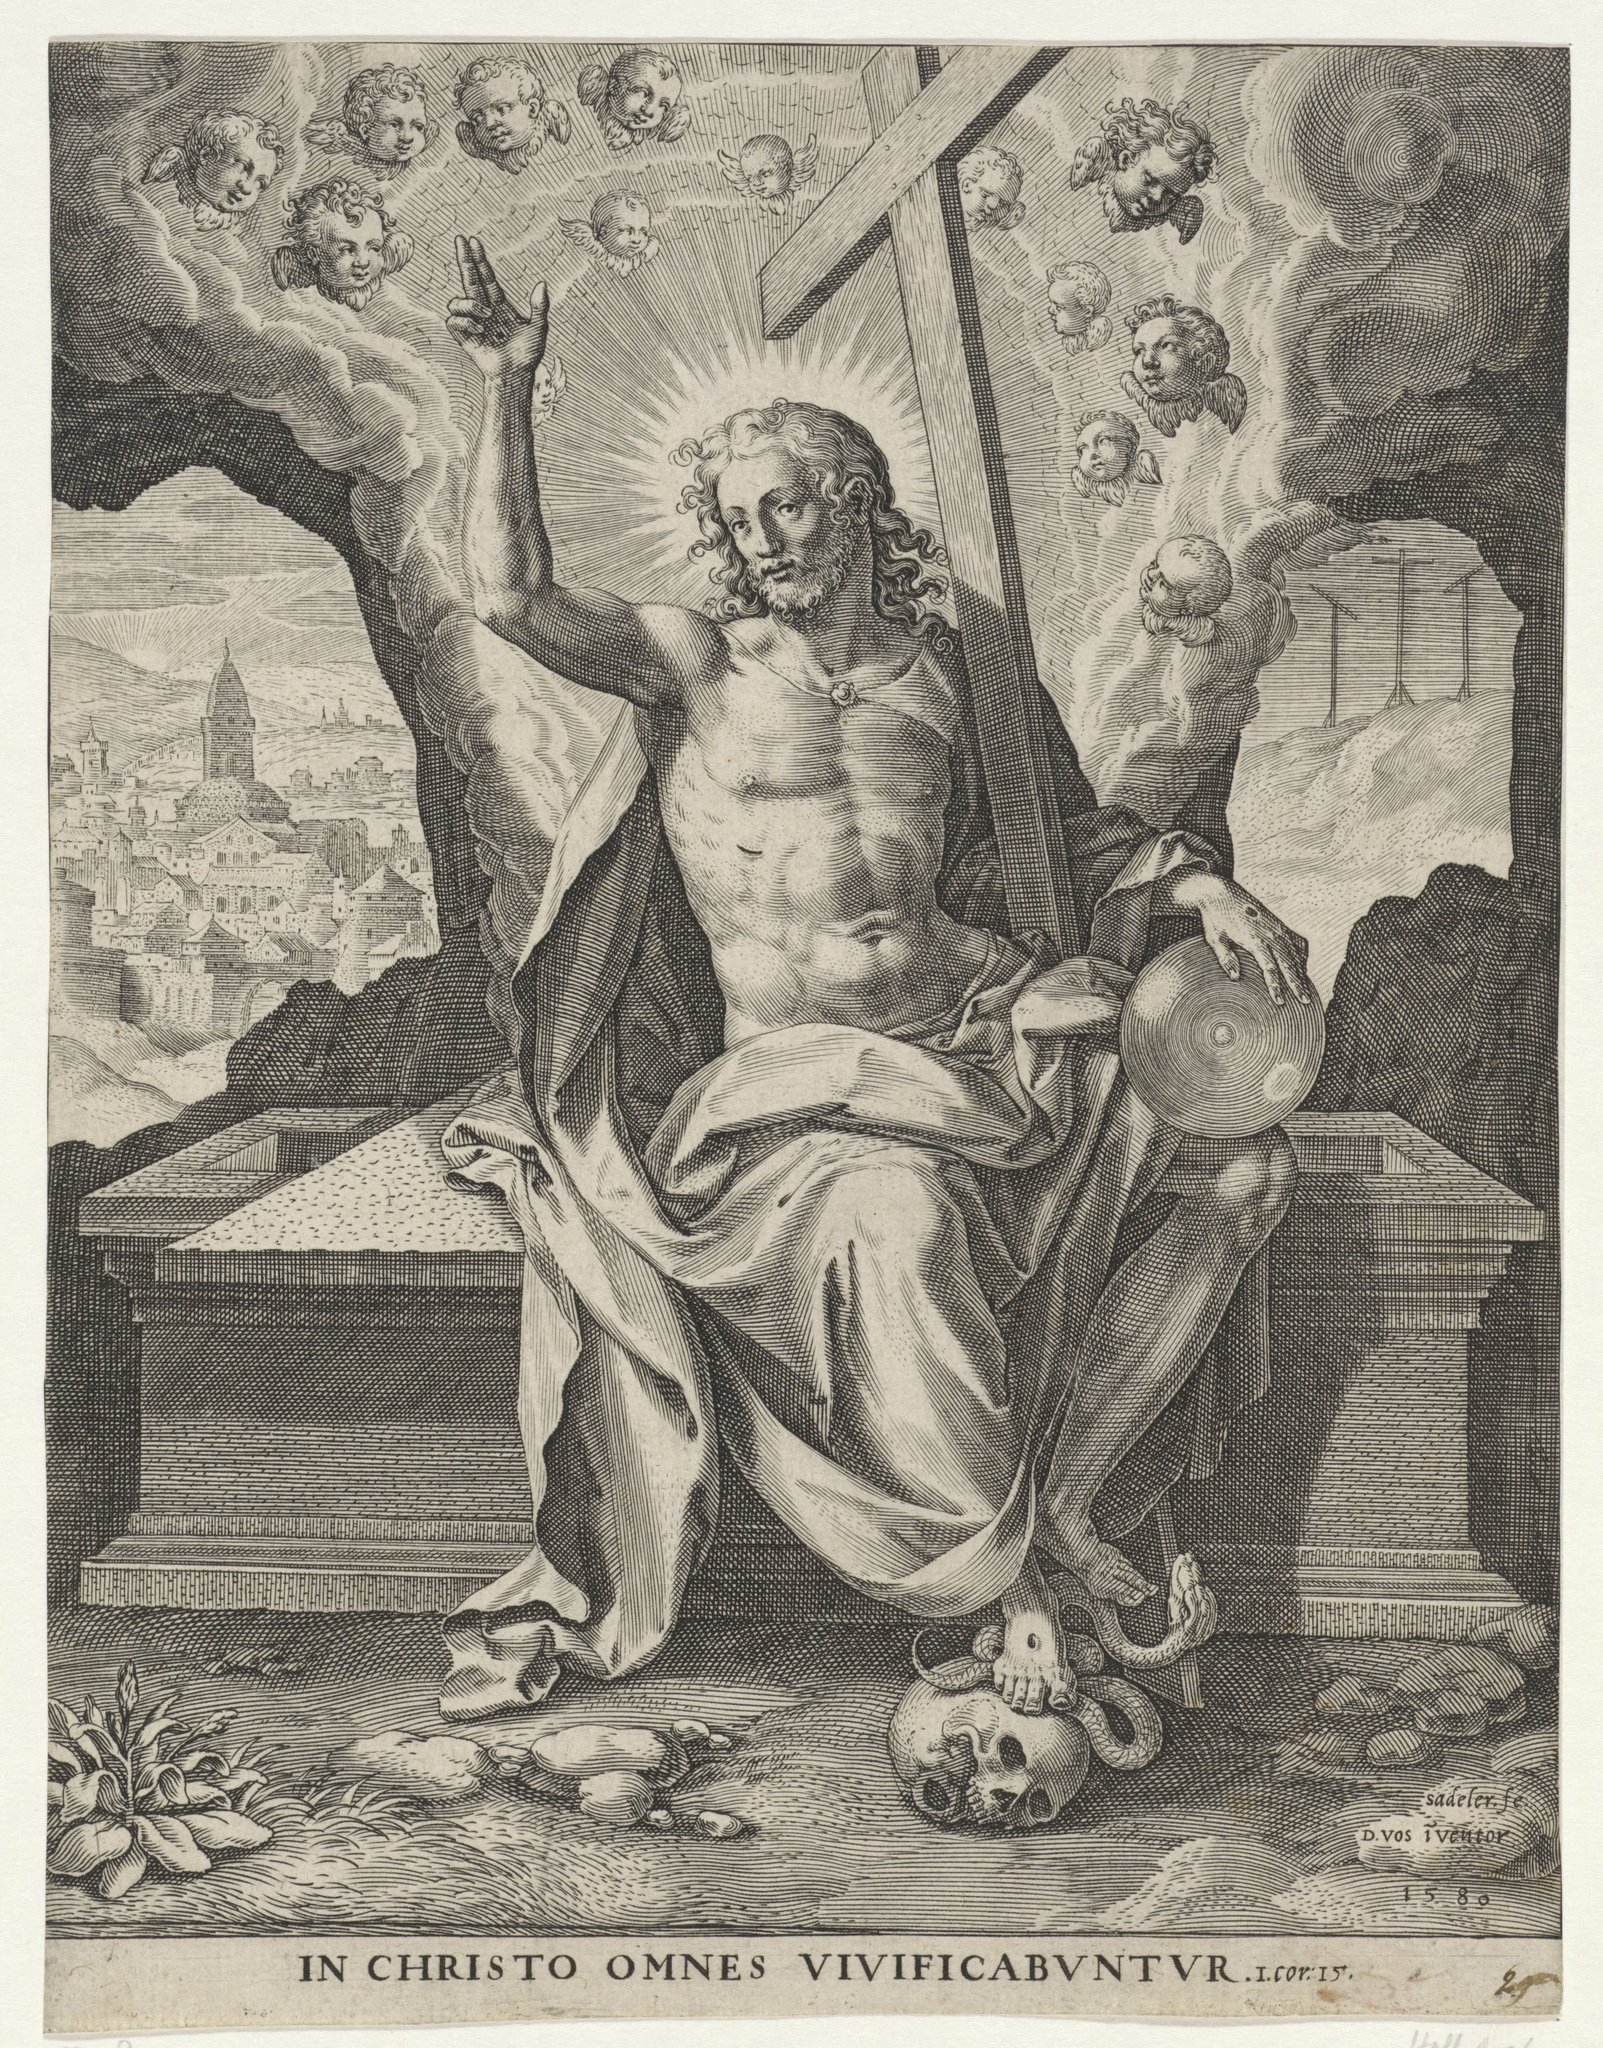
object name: print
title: Christus zittend op het graf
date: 1580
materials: paper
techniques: engraving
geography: antwerp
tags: christ sitting (enthroned) on the tomb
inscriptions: number: ‘29’, collector's mark: Lugt 240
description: Christus zittend op het graf met kruis en rijksappel in de hand. Aan zijn voeten een doodshoofd en een slang. Boven zijn hoofd cherubijntjes.